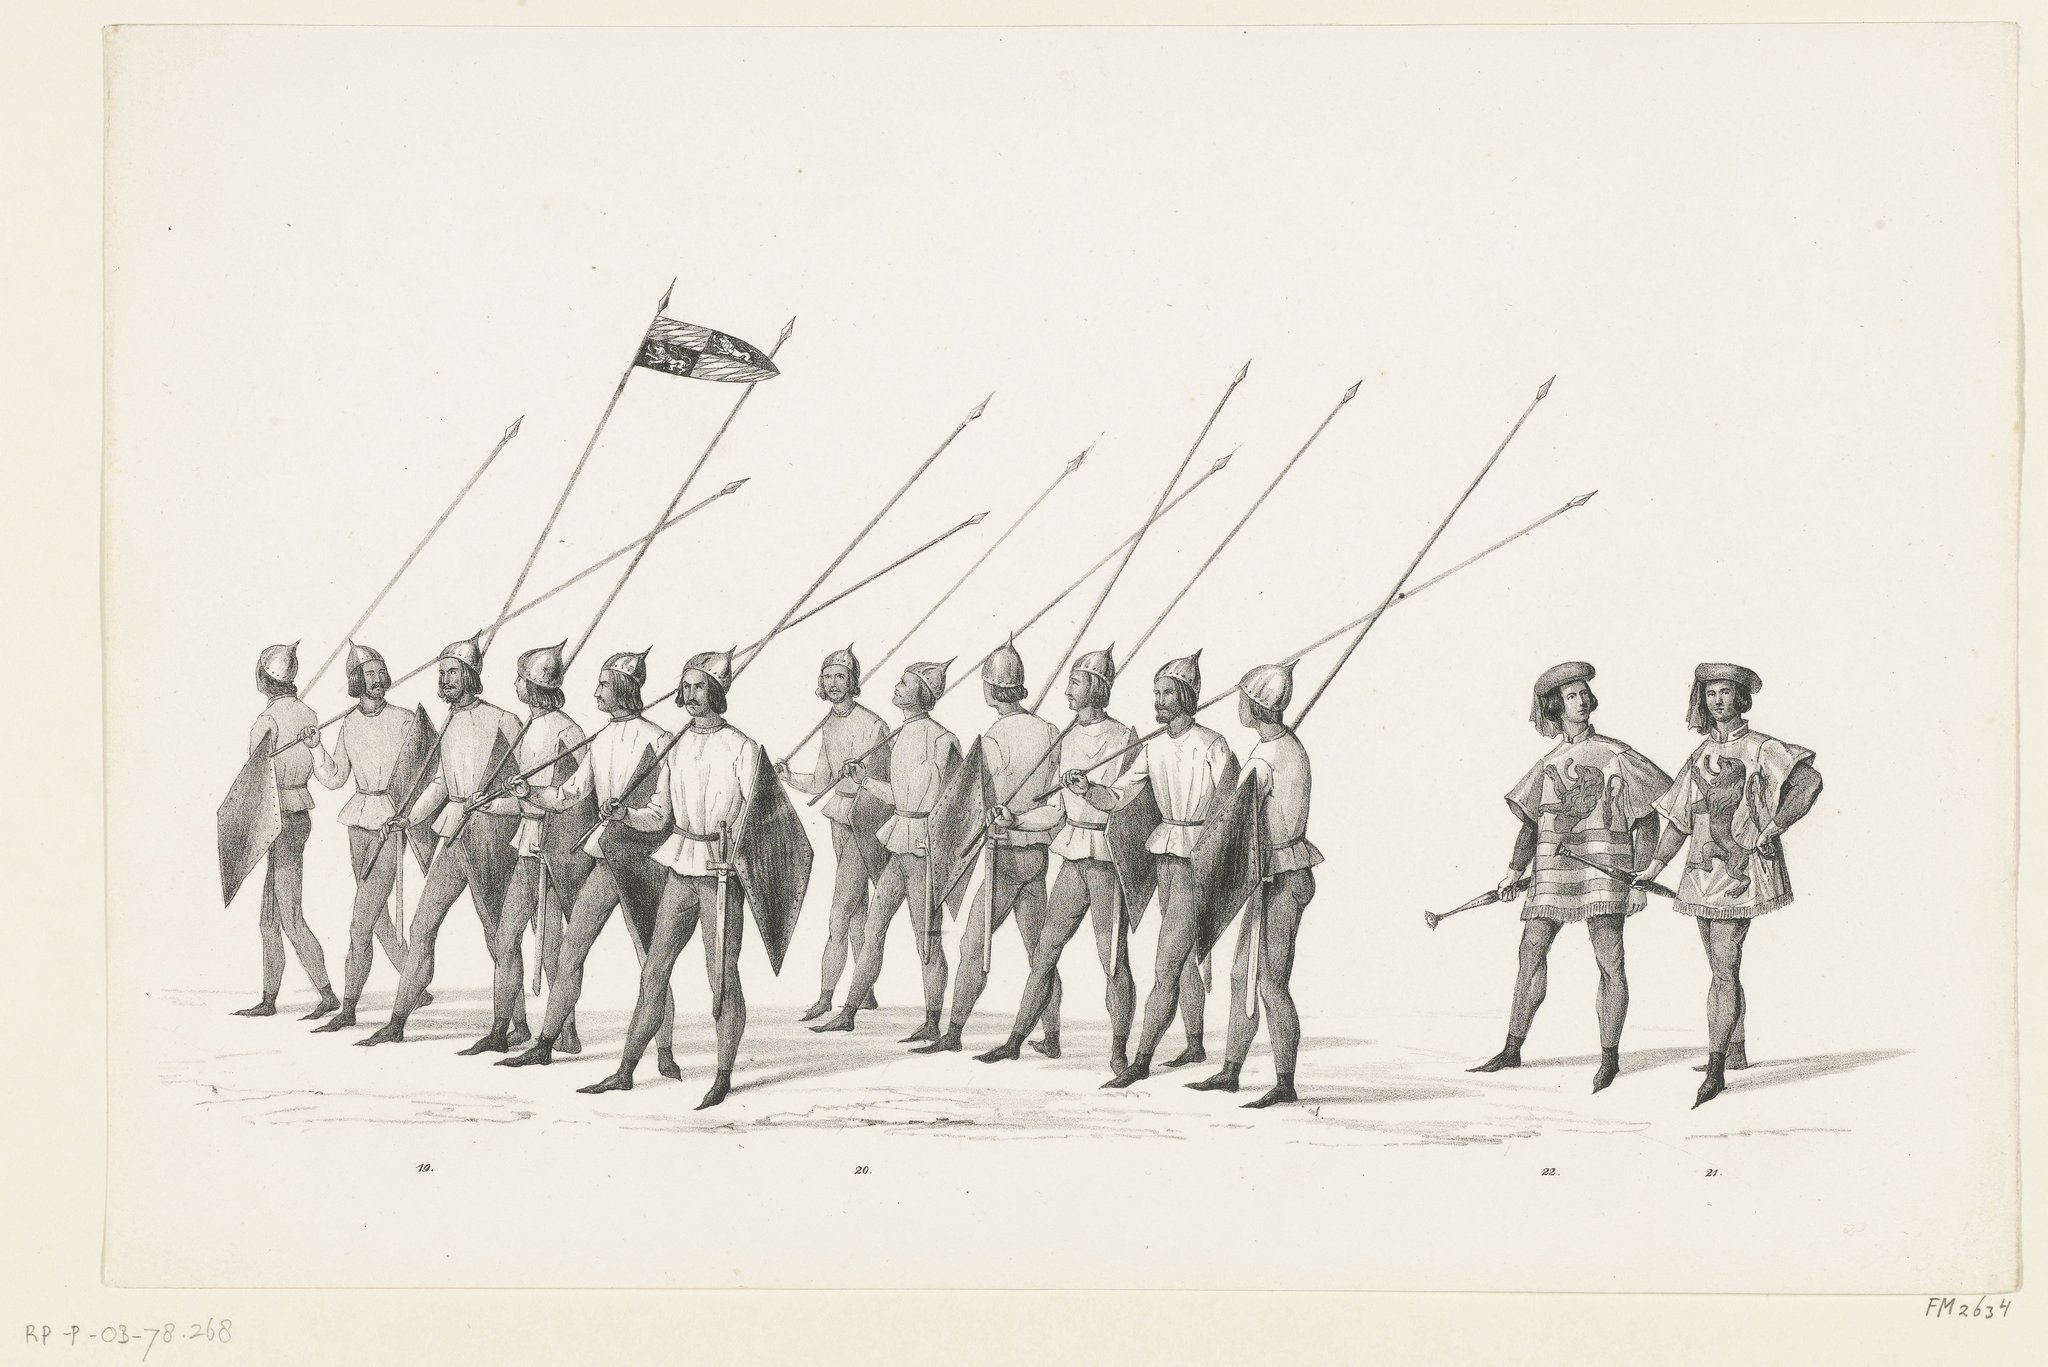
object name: print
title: Maskerade van de intocht van hertog Jan van Beieren te Leiden op 18 augustus 1420 door de Leidse studenten op 8 februari 1840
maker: Anonymous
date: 1840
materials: paper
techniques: lithograph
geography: netherlands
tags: jan van beieren, students' pageant, triumphal entry and public reception, pageant, 'entrée solennelle', 'joyeuse entrée', leiden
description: Optocht nrs 19-21: lijfwacht van de hertog. Onderdeel van de prentserie van de Maskerade van de intocht van hertog Jan van Beieren te Leiden op 18 augustus 1420 door de Leidse studenten op 8 februari 1840.